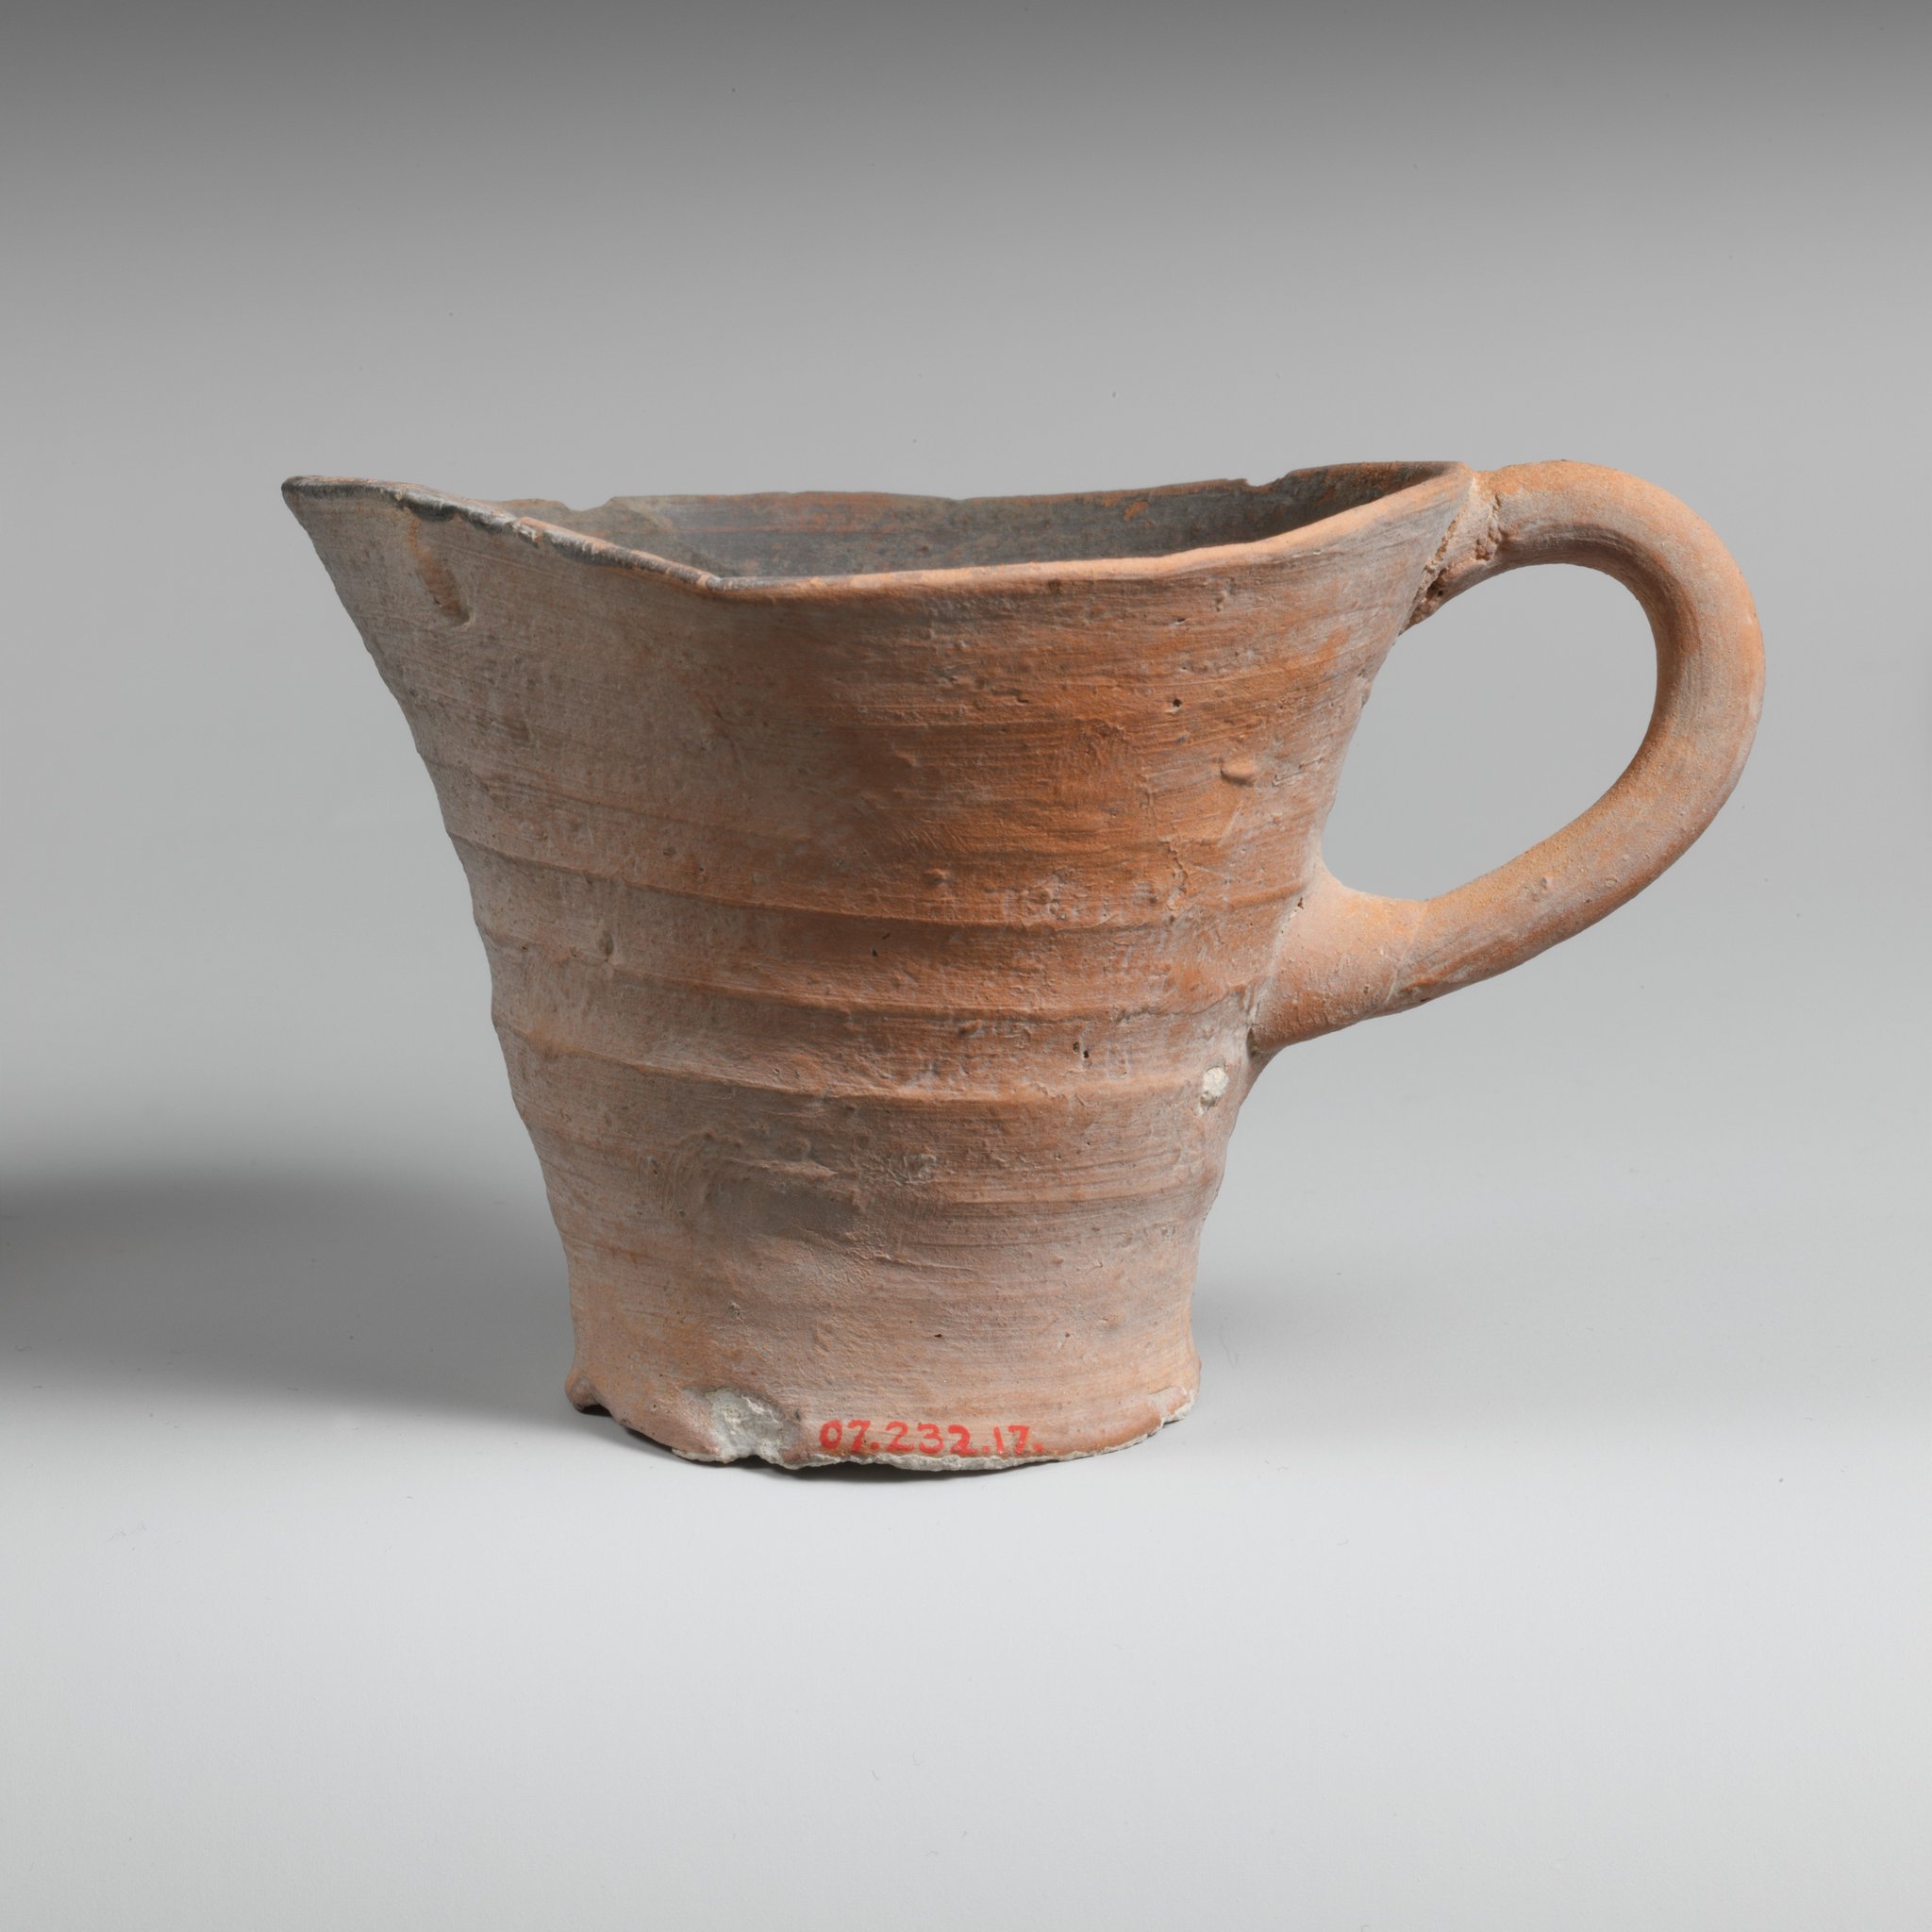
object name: cup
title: Terracotta one-handled cup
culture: minoan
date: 1750-1600 BCE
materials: terracotta